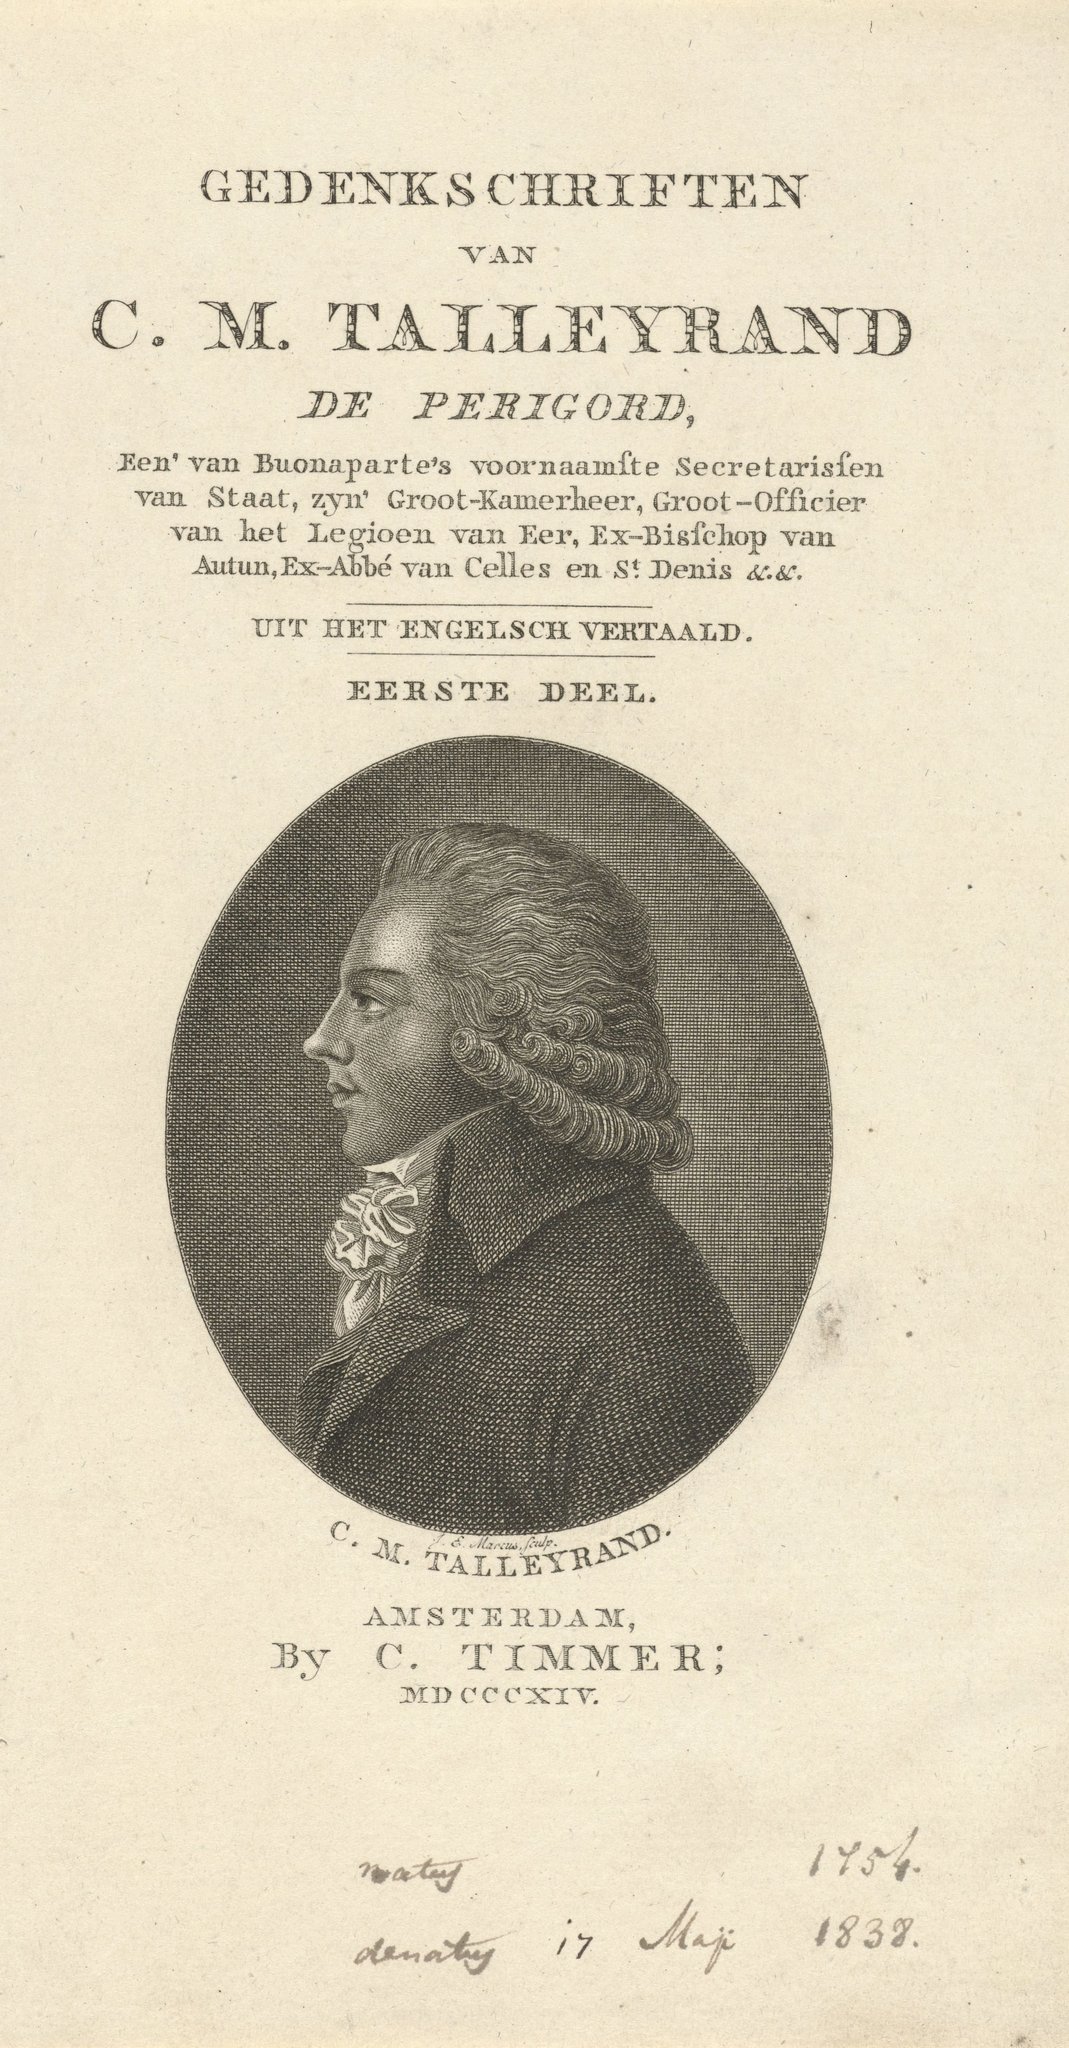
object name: titelblad, titelpagina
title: Portret van Charles Maurice Talleyrand-Périgord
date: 1814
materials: paper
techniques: engraving, etching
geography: amsterdam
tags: paris, politician, charles maurice hertog van talleyrand-périgord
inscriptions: inscription: ‘natus 1756/ denatus Maij 1837’, collector's mark: Lugt 2228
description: Titelpagina voor: C.M. de Talleyrand de Périgord [vertaald door Lewis Goldsmith], Gedenkschriften van C. M. Talleyrand de Perigord, een' van Buonaparte's voornaamste secretarissen van Staat[...]. Amsterdam: C.Timmer, 1814.